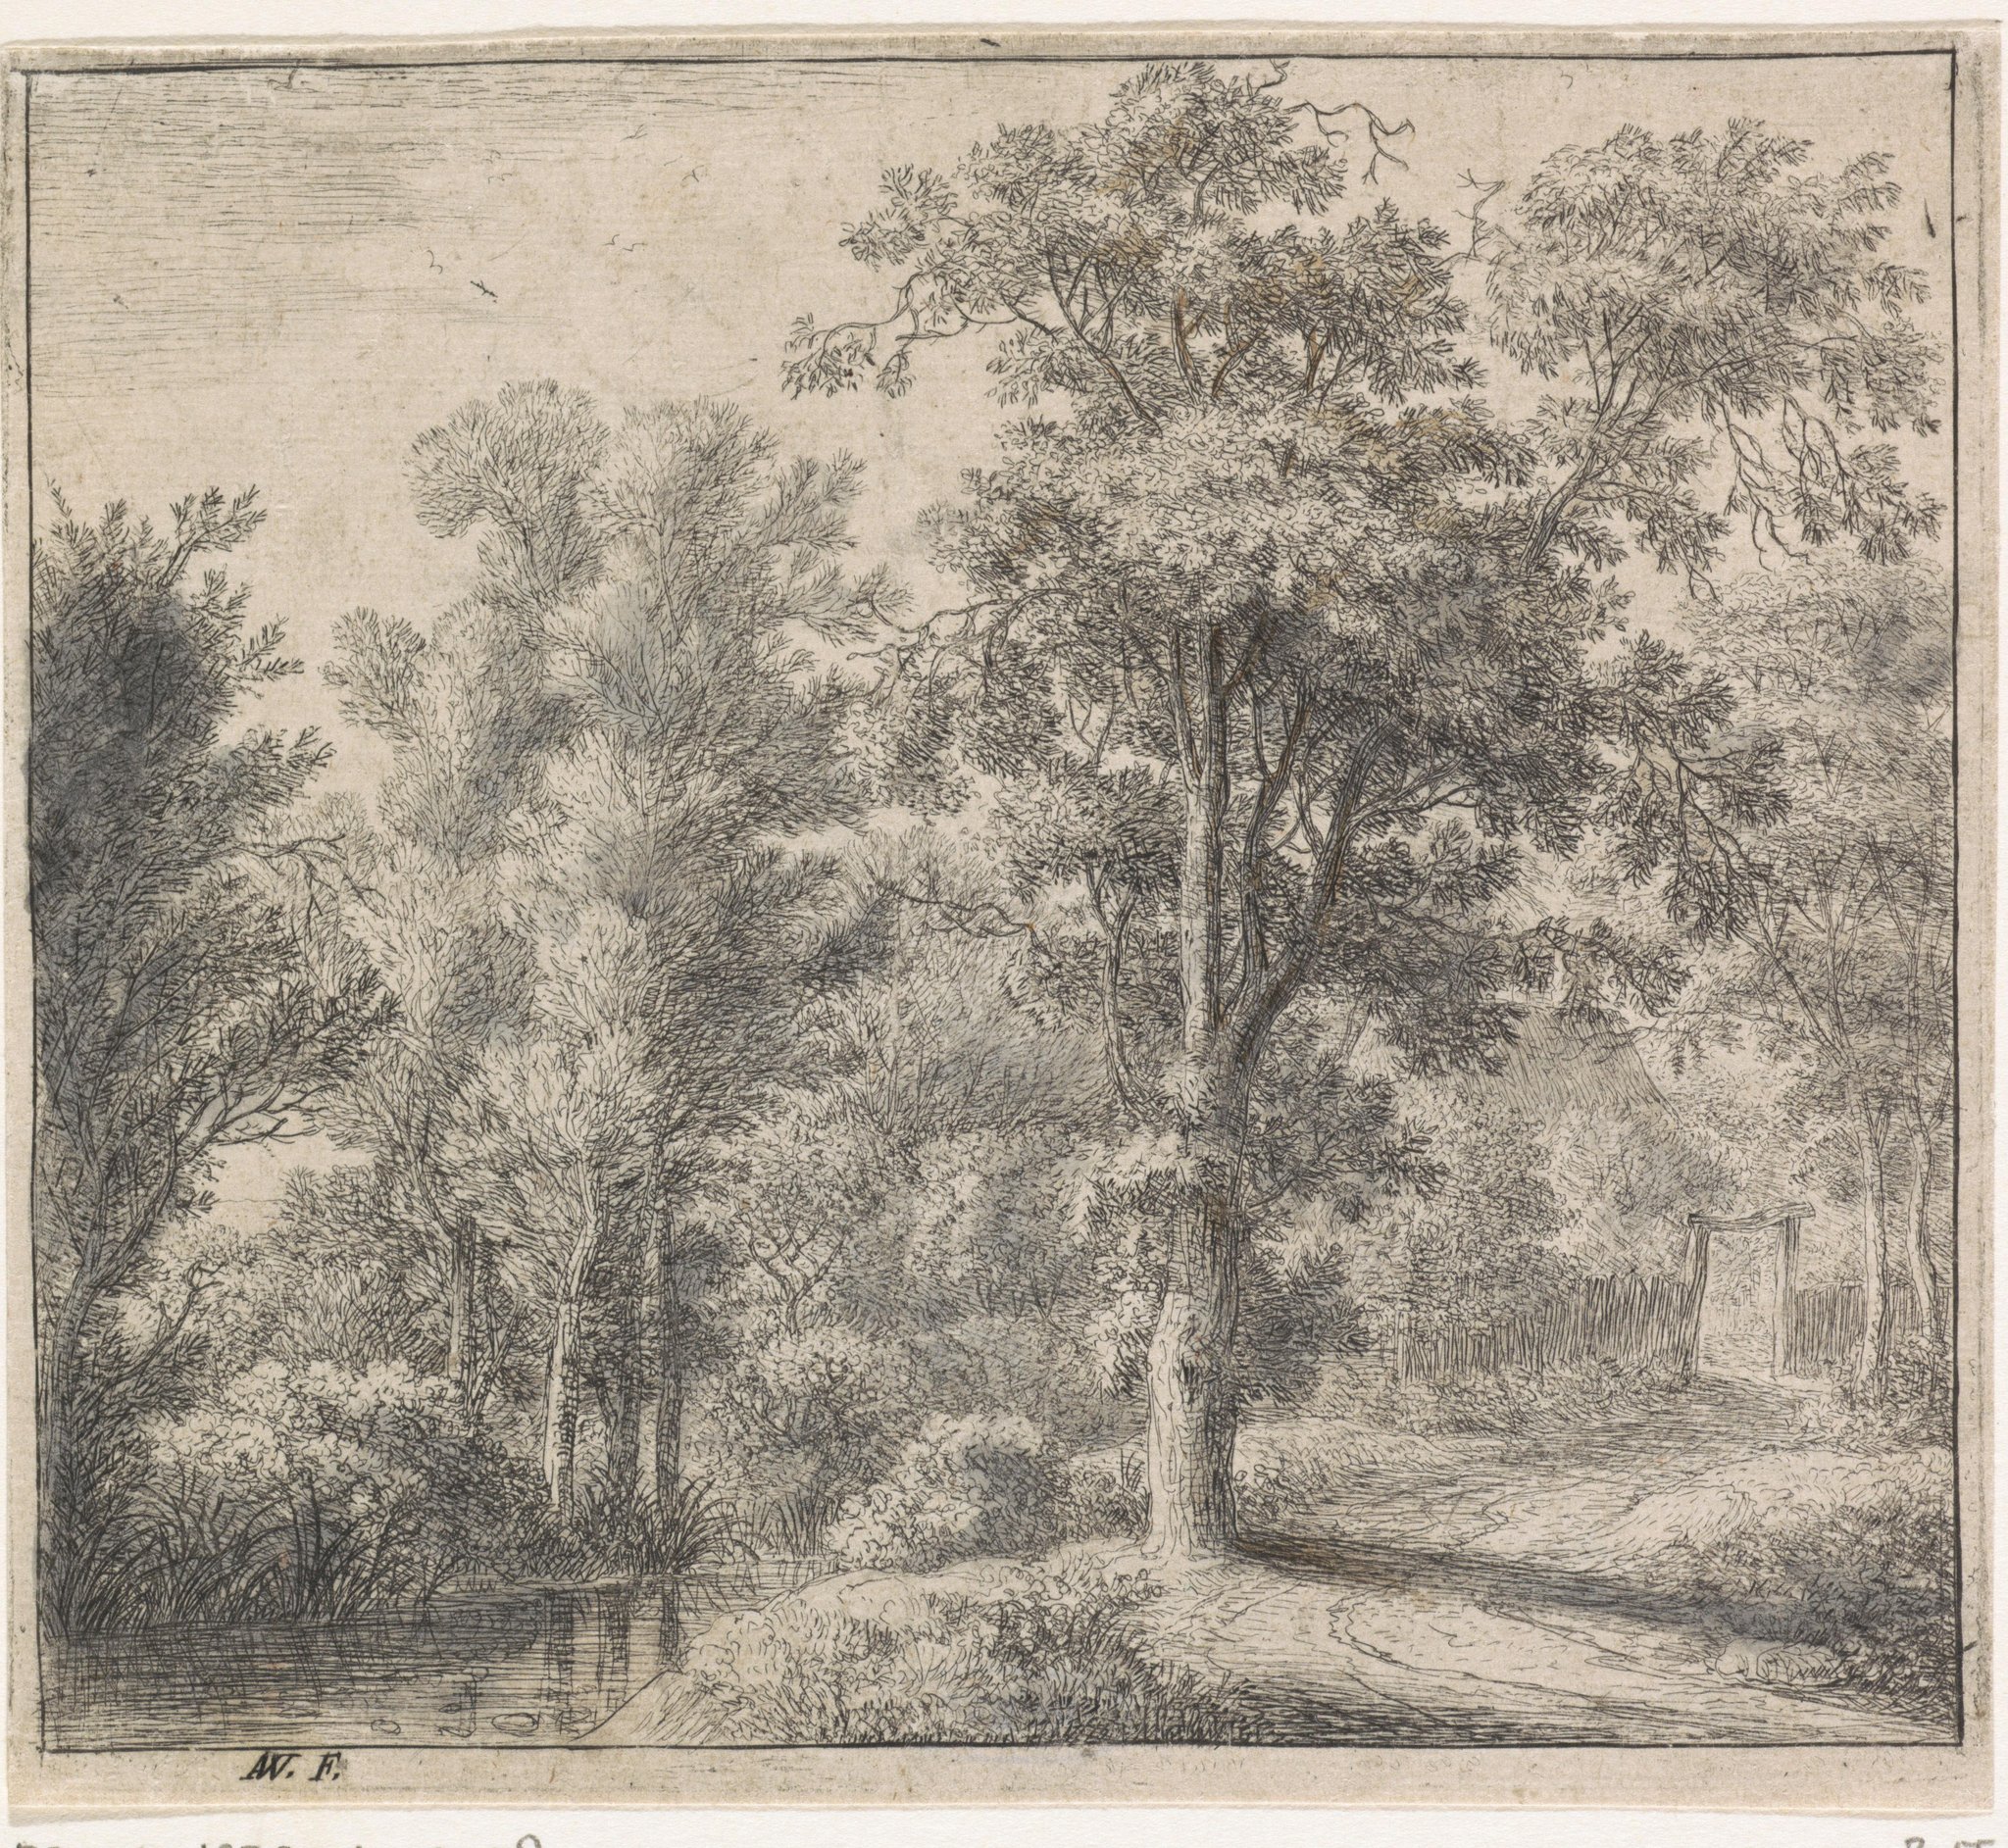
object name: print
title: Ingang van het bos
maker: anthonie waterloo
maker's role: draughtsman, painter, print maker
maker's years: 1609-1690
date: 1630-1663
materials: paper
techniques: brush, etching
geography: amsterdam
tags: gate, entrance, forest, wood, brook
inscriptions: collector's mark: Lugt 2228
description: Links stroomt een beek door een bos. Rechts loopt een pad en in de verte is de toegangspoort te zien.